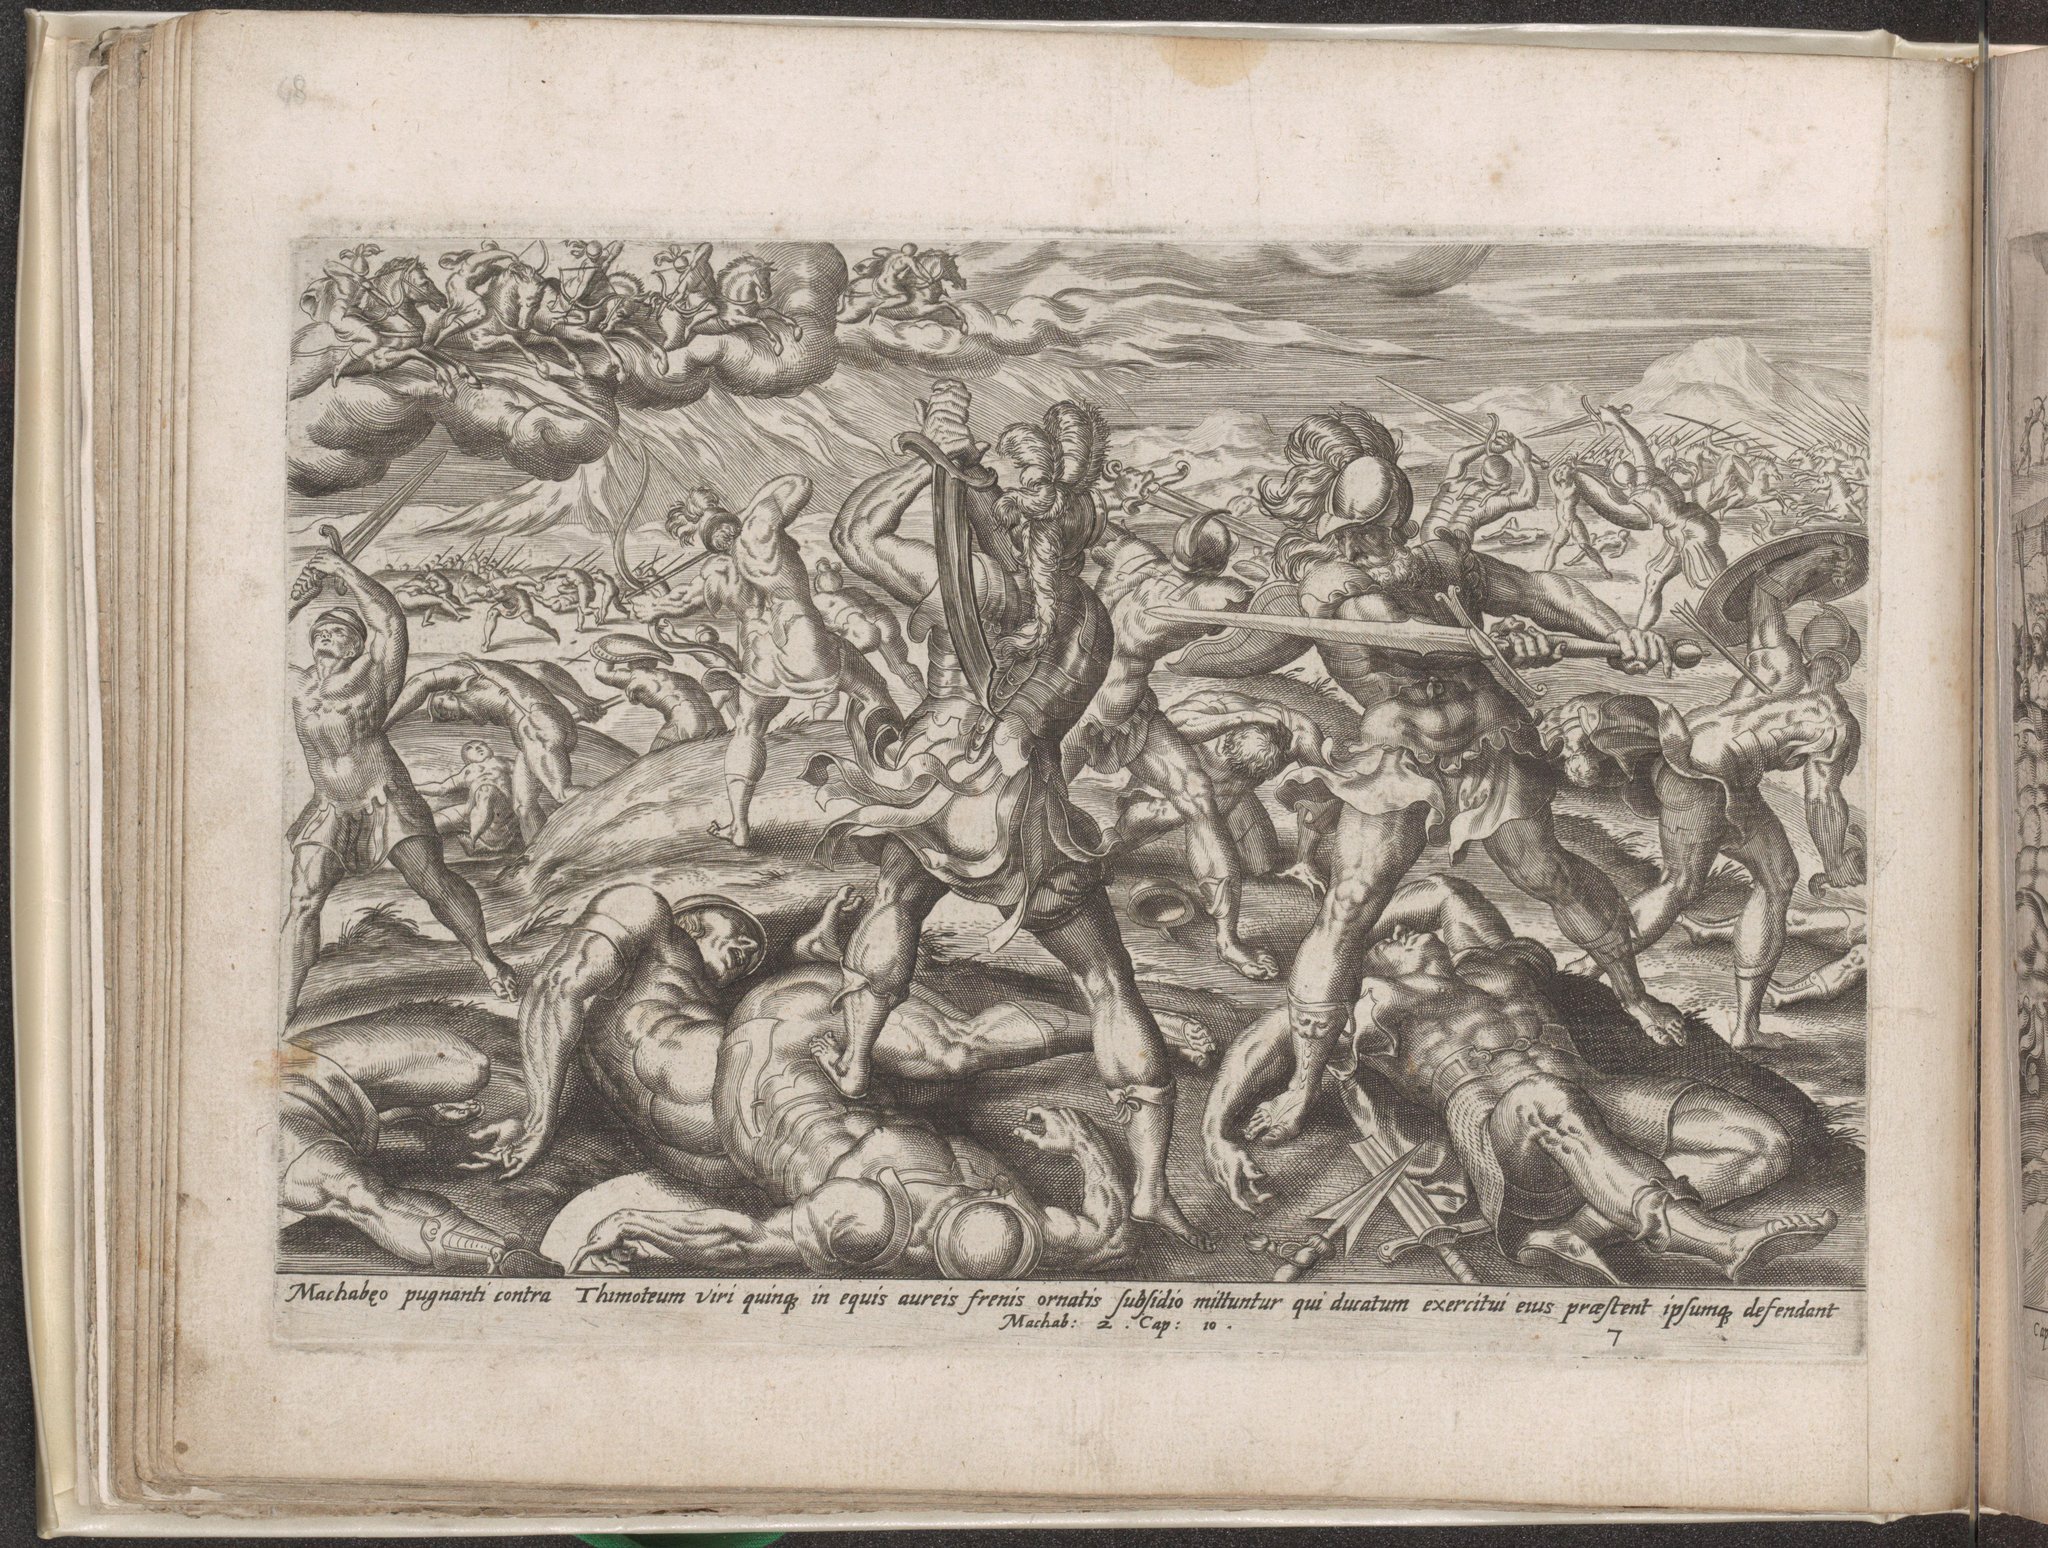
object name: album leaf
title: Geschiedenis van de Makkabeeën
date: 1572-1576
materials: paper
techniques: engraving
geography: antwerp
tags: riders are seen in the sky above the city of jerusalem (2 maccabees 5:2)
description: Het leger van Timoteüs trekt op tegen Judea en vecht tegen de Joden. Aan de hemel verschijnen vijf ruiters op paarden met gouden teugels, die zich aan het hoofd stellen van de Joodse troepen. Ze bestoken de mannen van Timoteüs met pijlen en bliksem. Onder de voorstelling een verwijzing in het Latijn naar de Bijbeltekst in 2 Makk. 10. Deze prent maakt deel uit van een album.